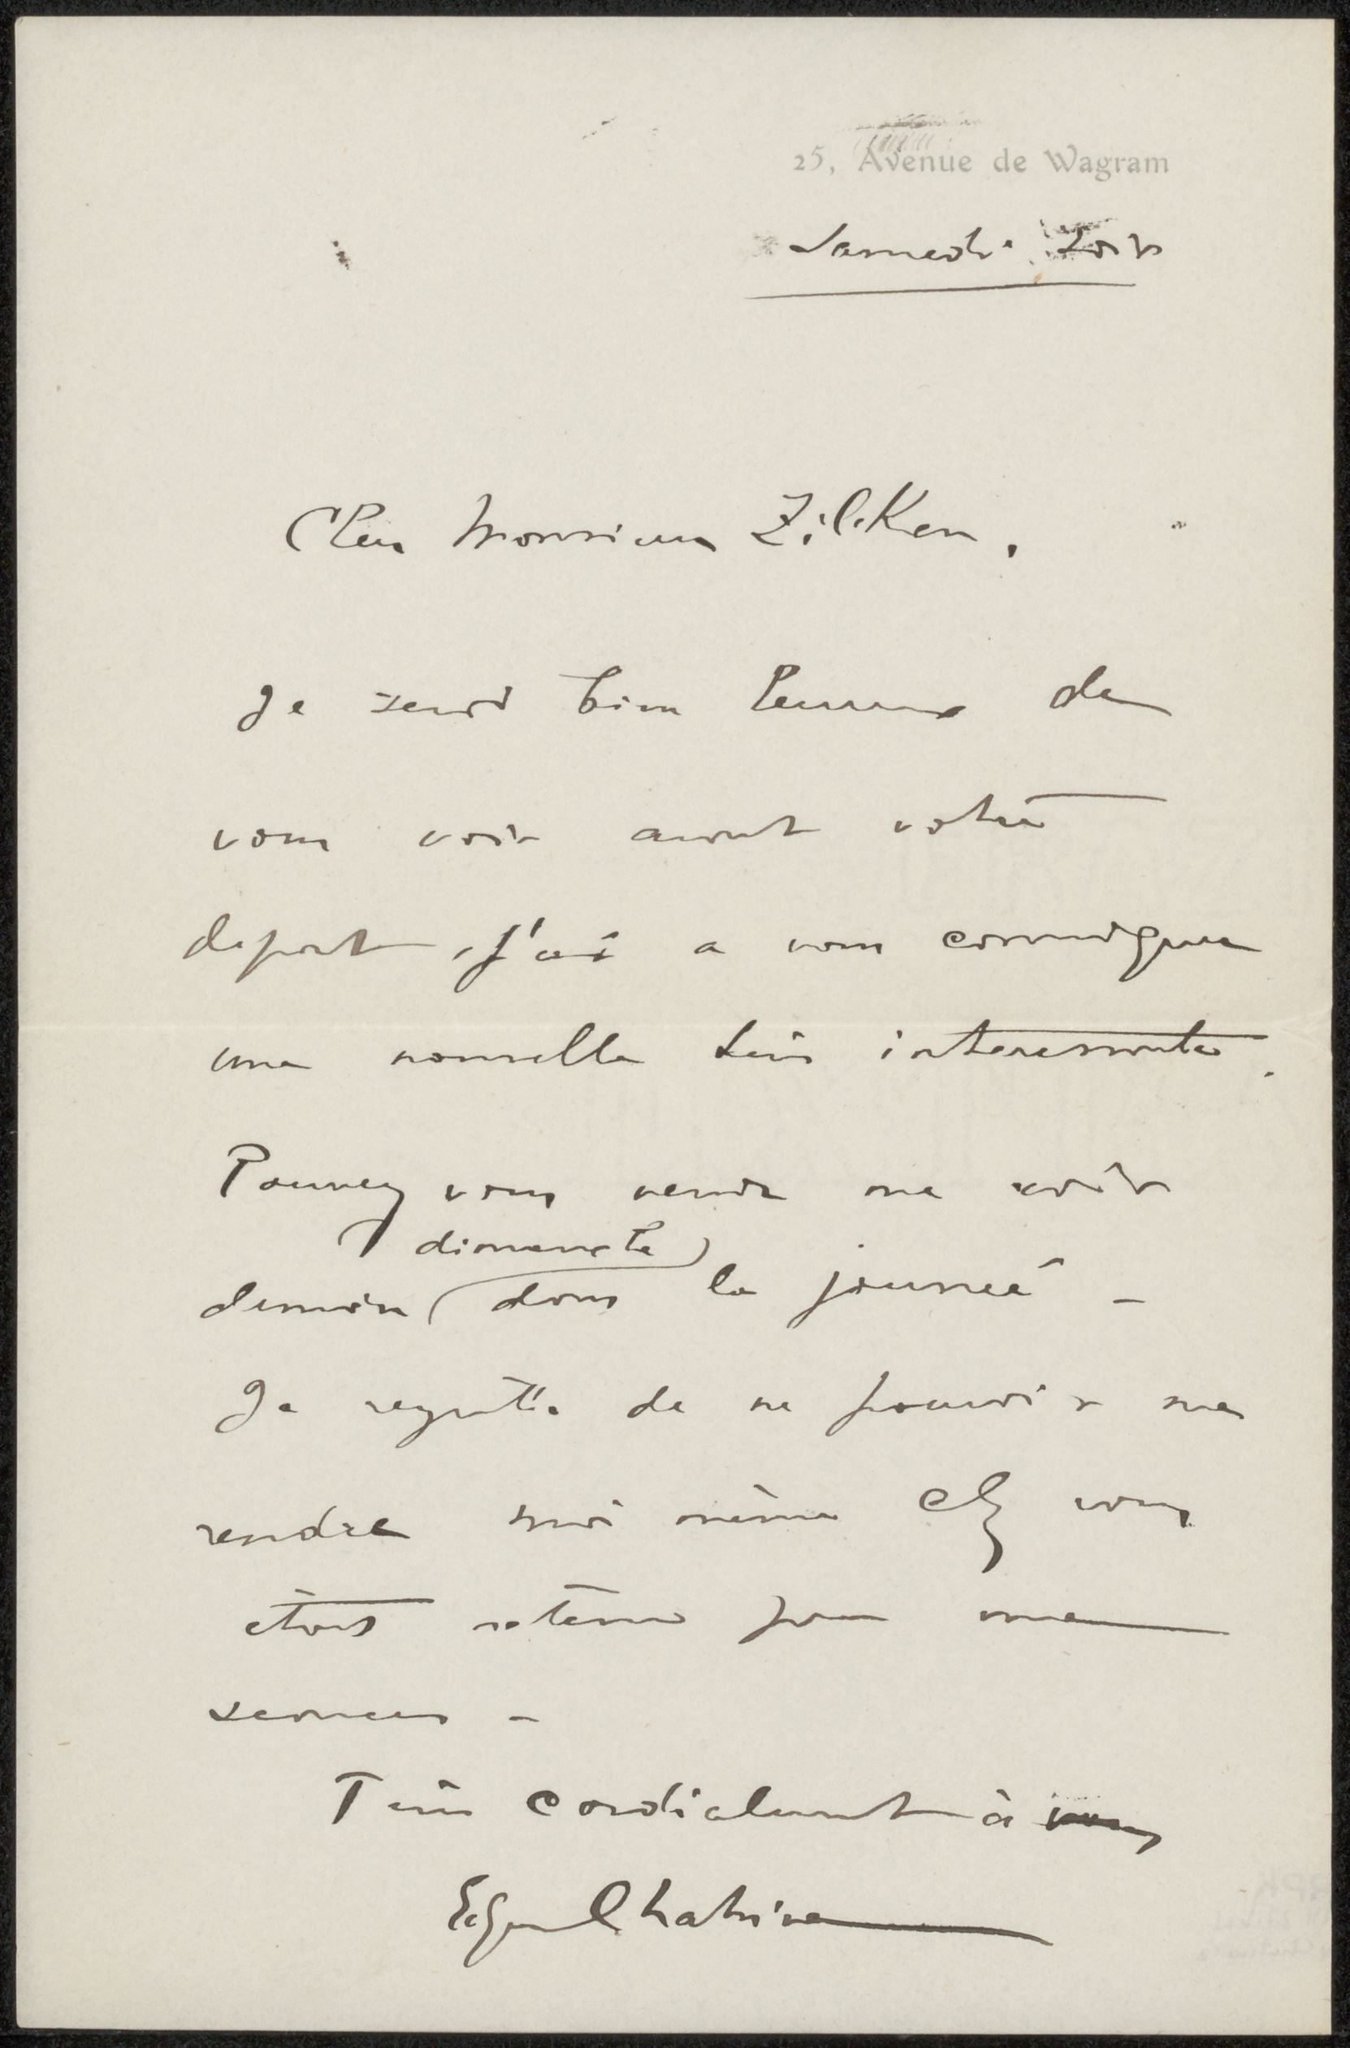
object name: letter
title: Brief aan Philip Zilcken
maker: chatine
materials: ink, paper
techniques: pen, writing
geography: paris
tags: the hague, painter, philip zilcken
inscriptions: watermark, collector's mark: ‘RPK’